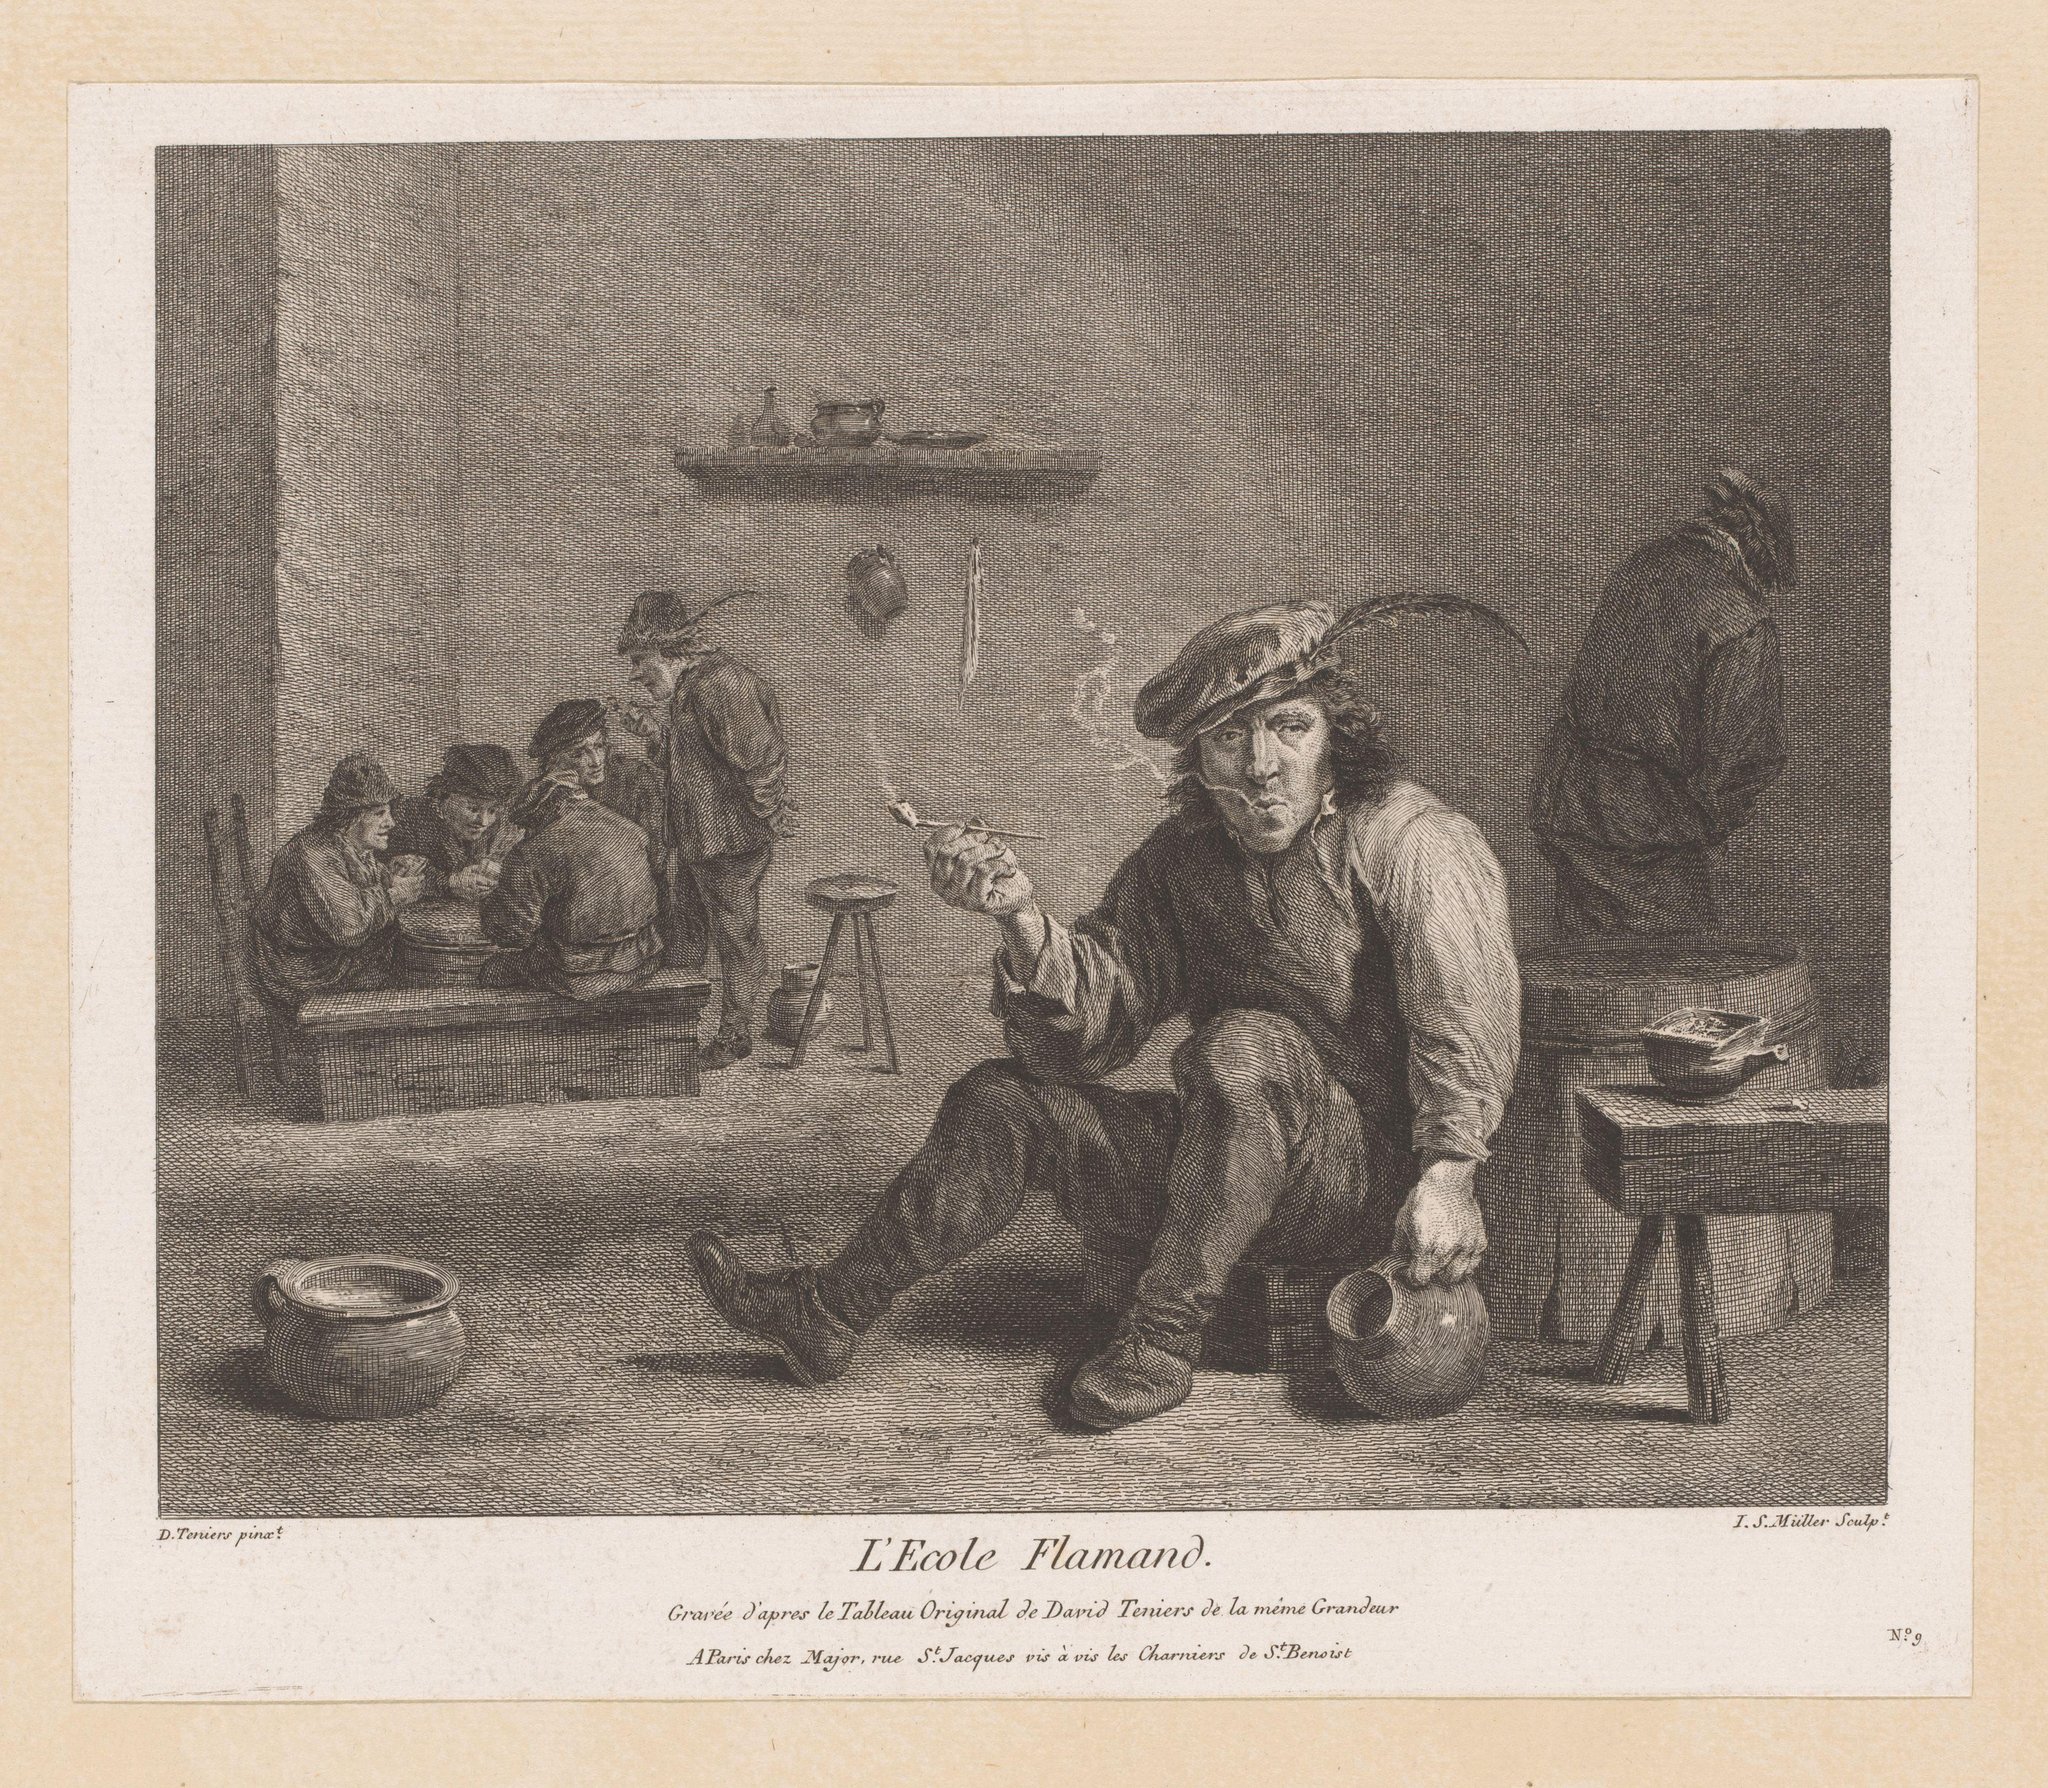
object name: print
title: Interieur met rokende man en groep kaartspelers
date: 1700-1799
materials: paper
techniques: etching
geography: paris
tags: pipe ~ tobacco, card games, interior of the house, urination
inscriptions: collector's mark: Lugt 240